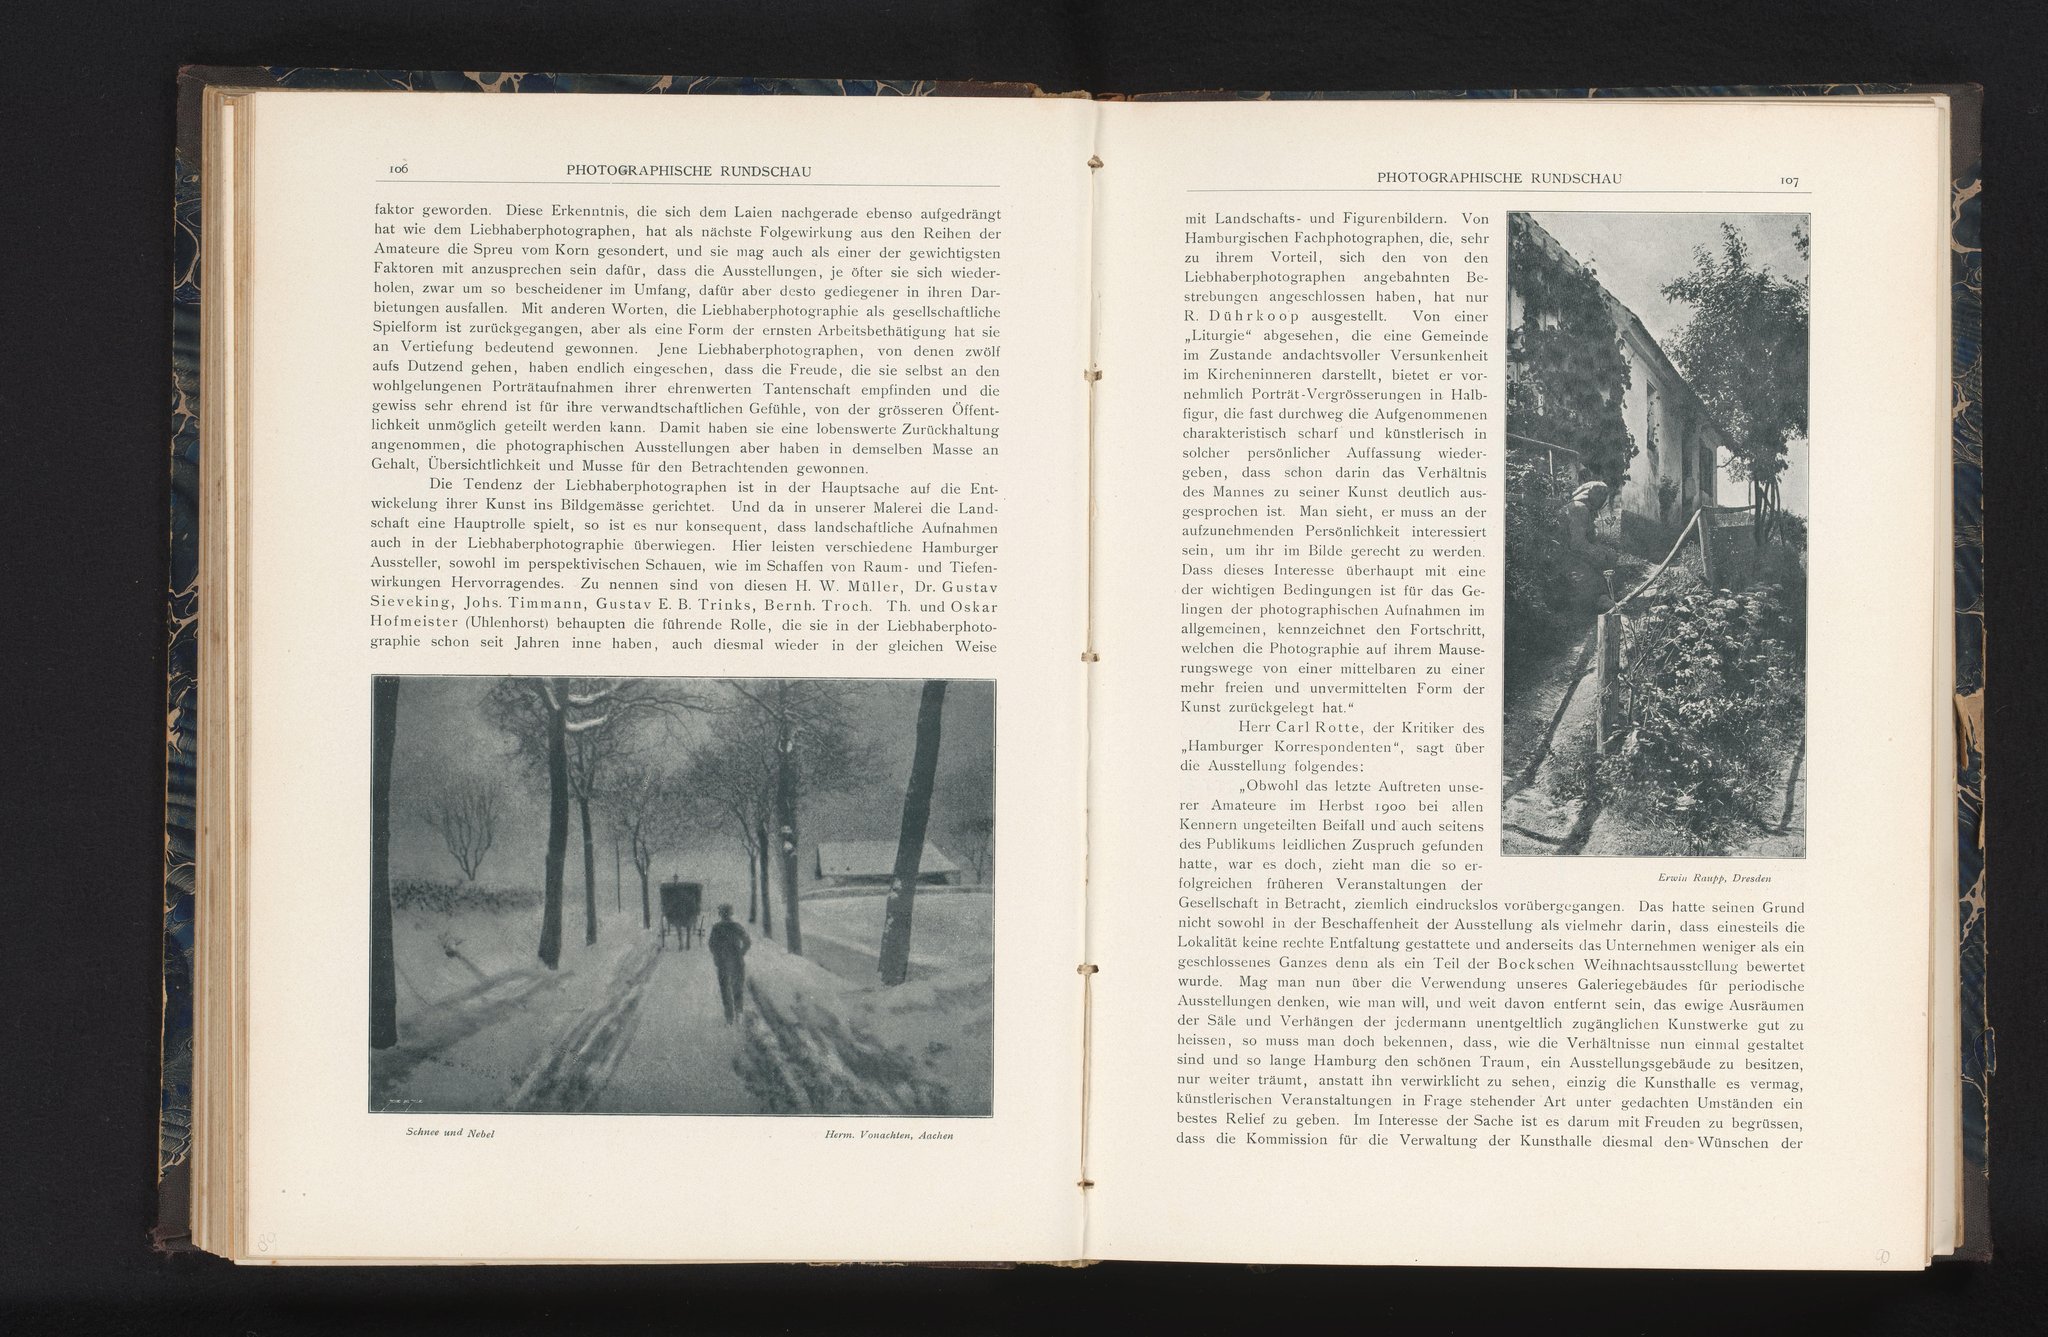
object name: photomechanical print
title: Schnee und Nebel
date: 1897-1902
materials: paper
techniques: autotype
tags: road, path, snow